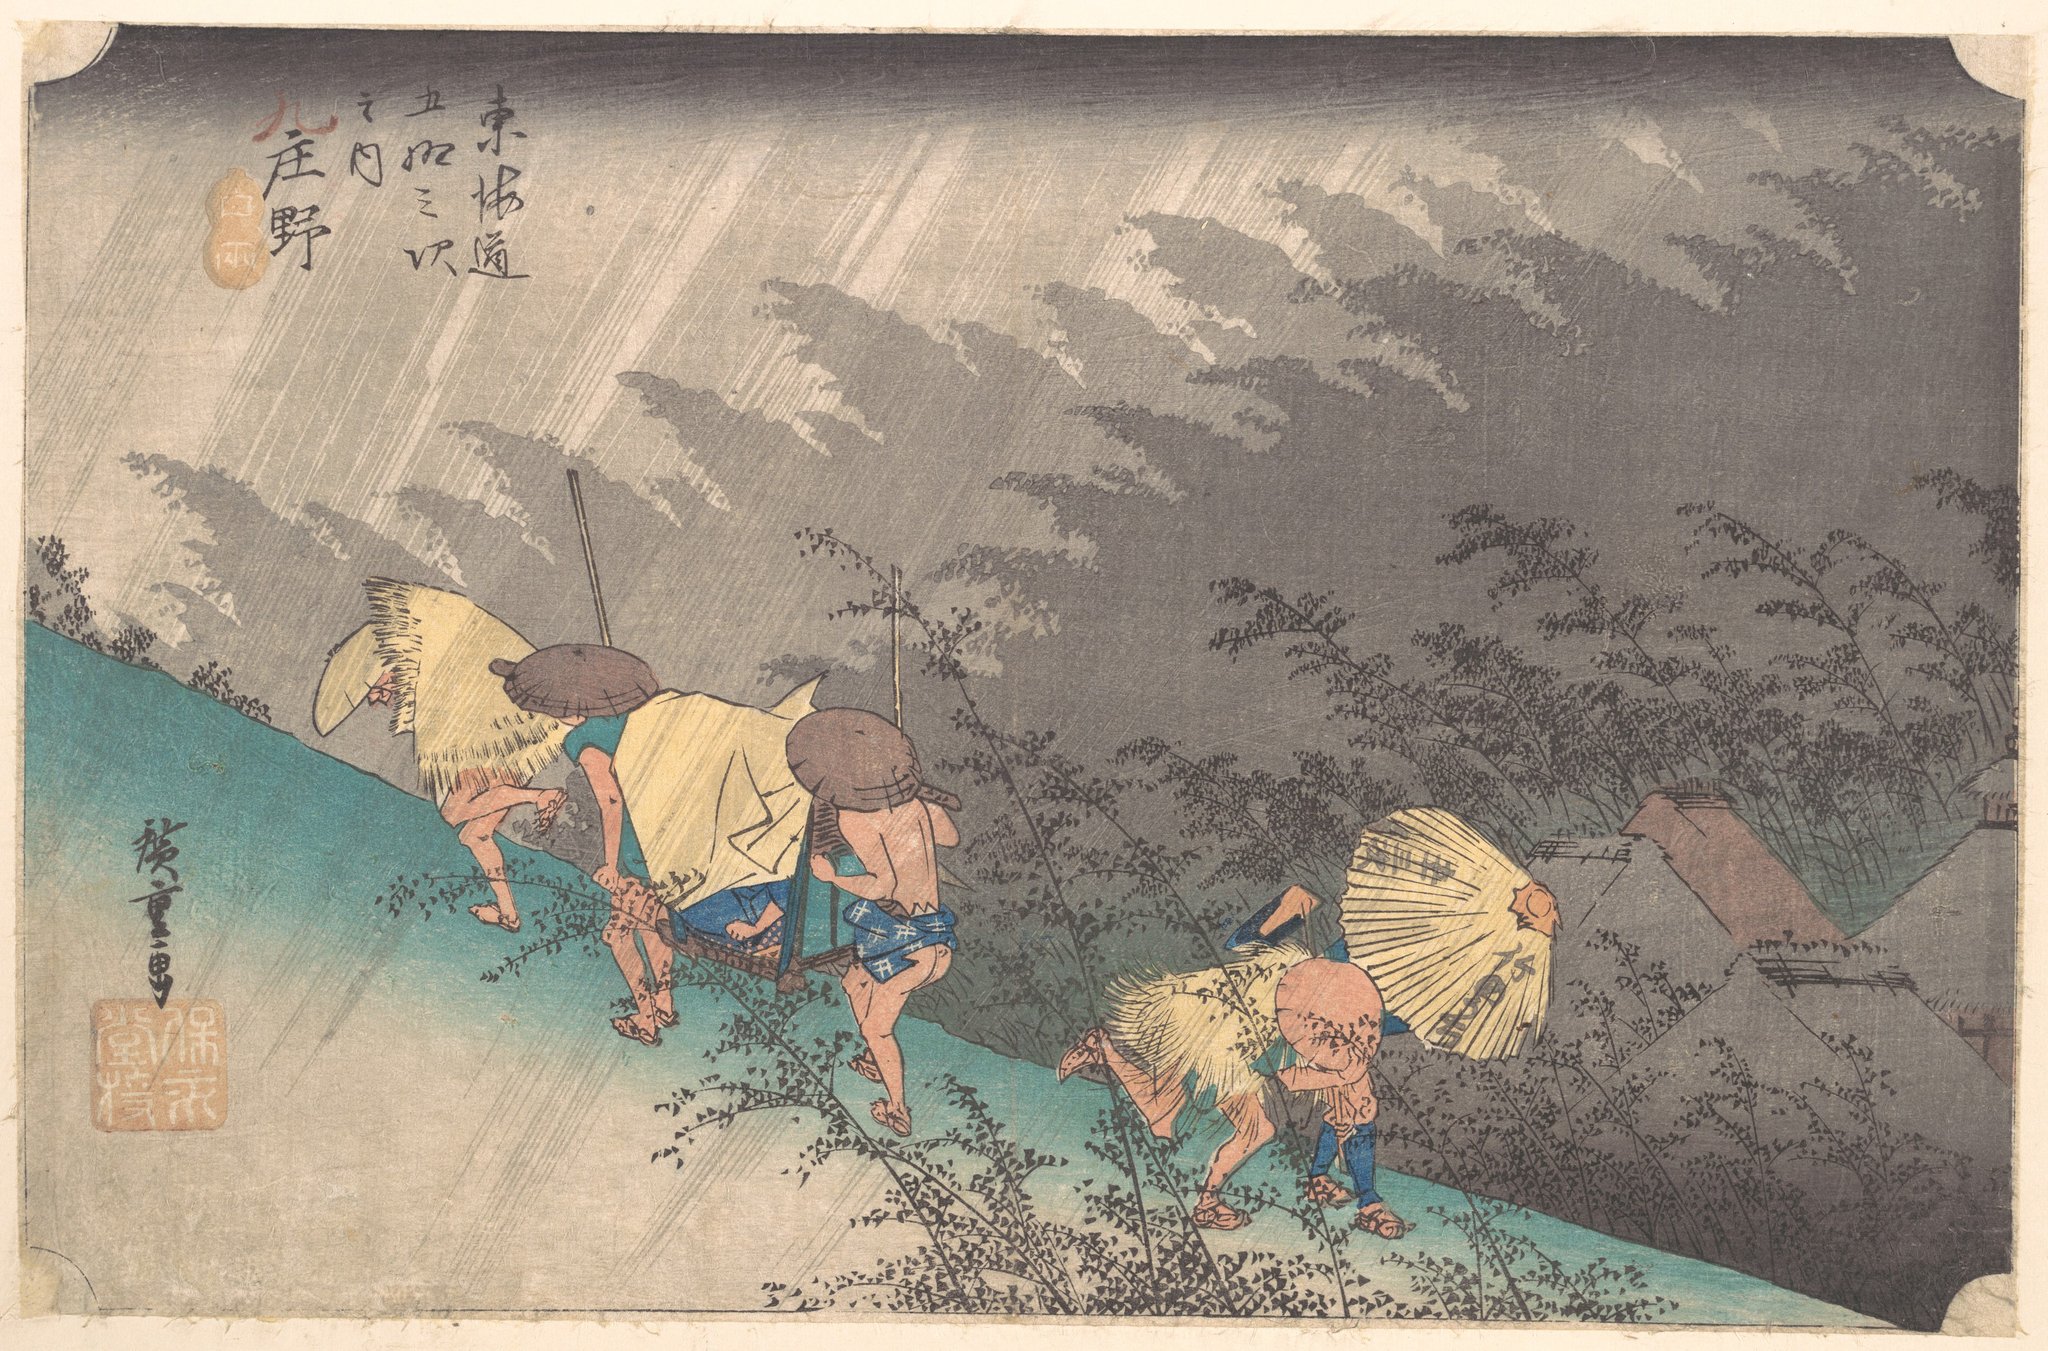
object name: print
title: Shower at Shōno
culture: japanese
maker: utagawa hiroshige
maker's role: artist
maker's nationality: japanese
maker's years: 1797-1858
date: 1834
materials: ink, paper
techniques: woodblock print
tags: men,rain